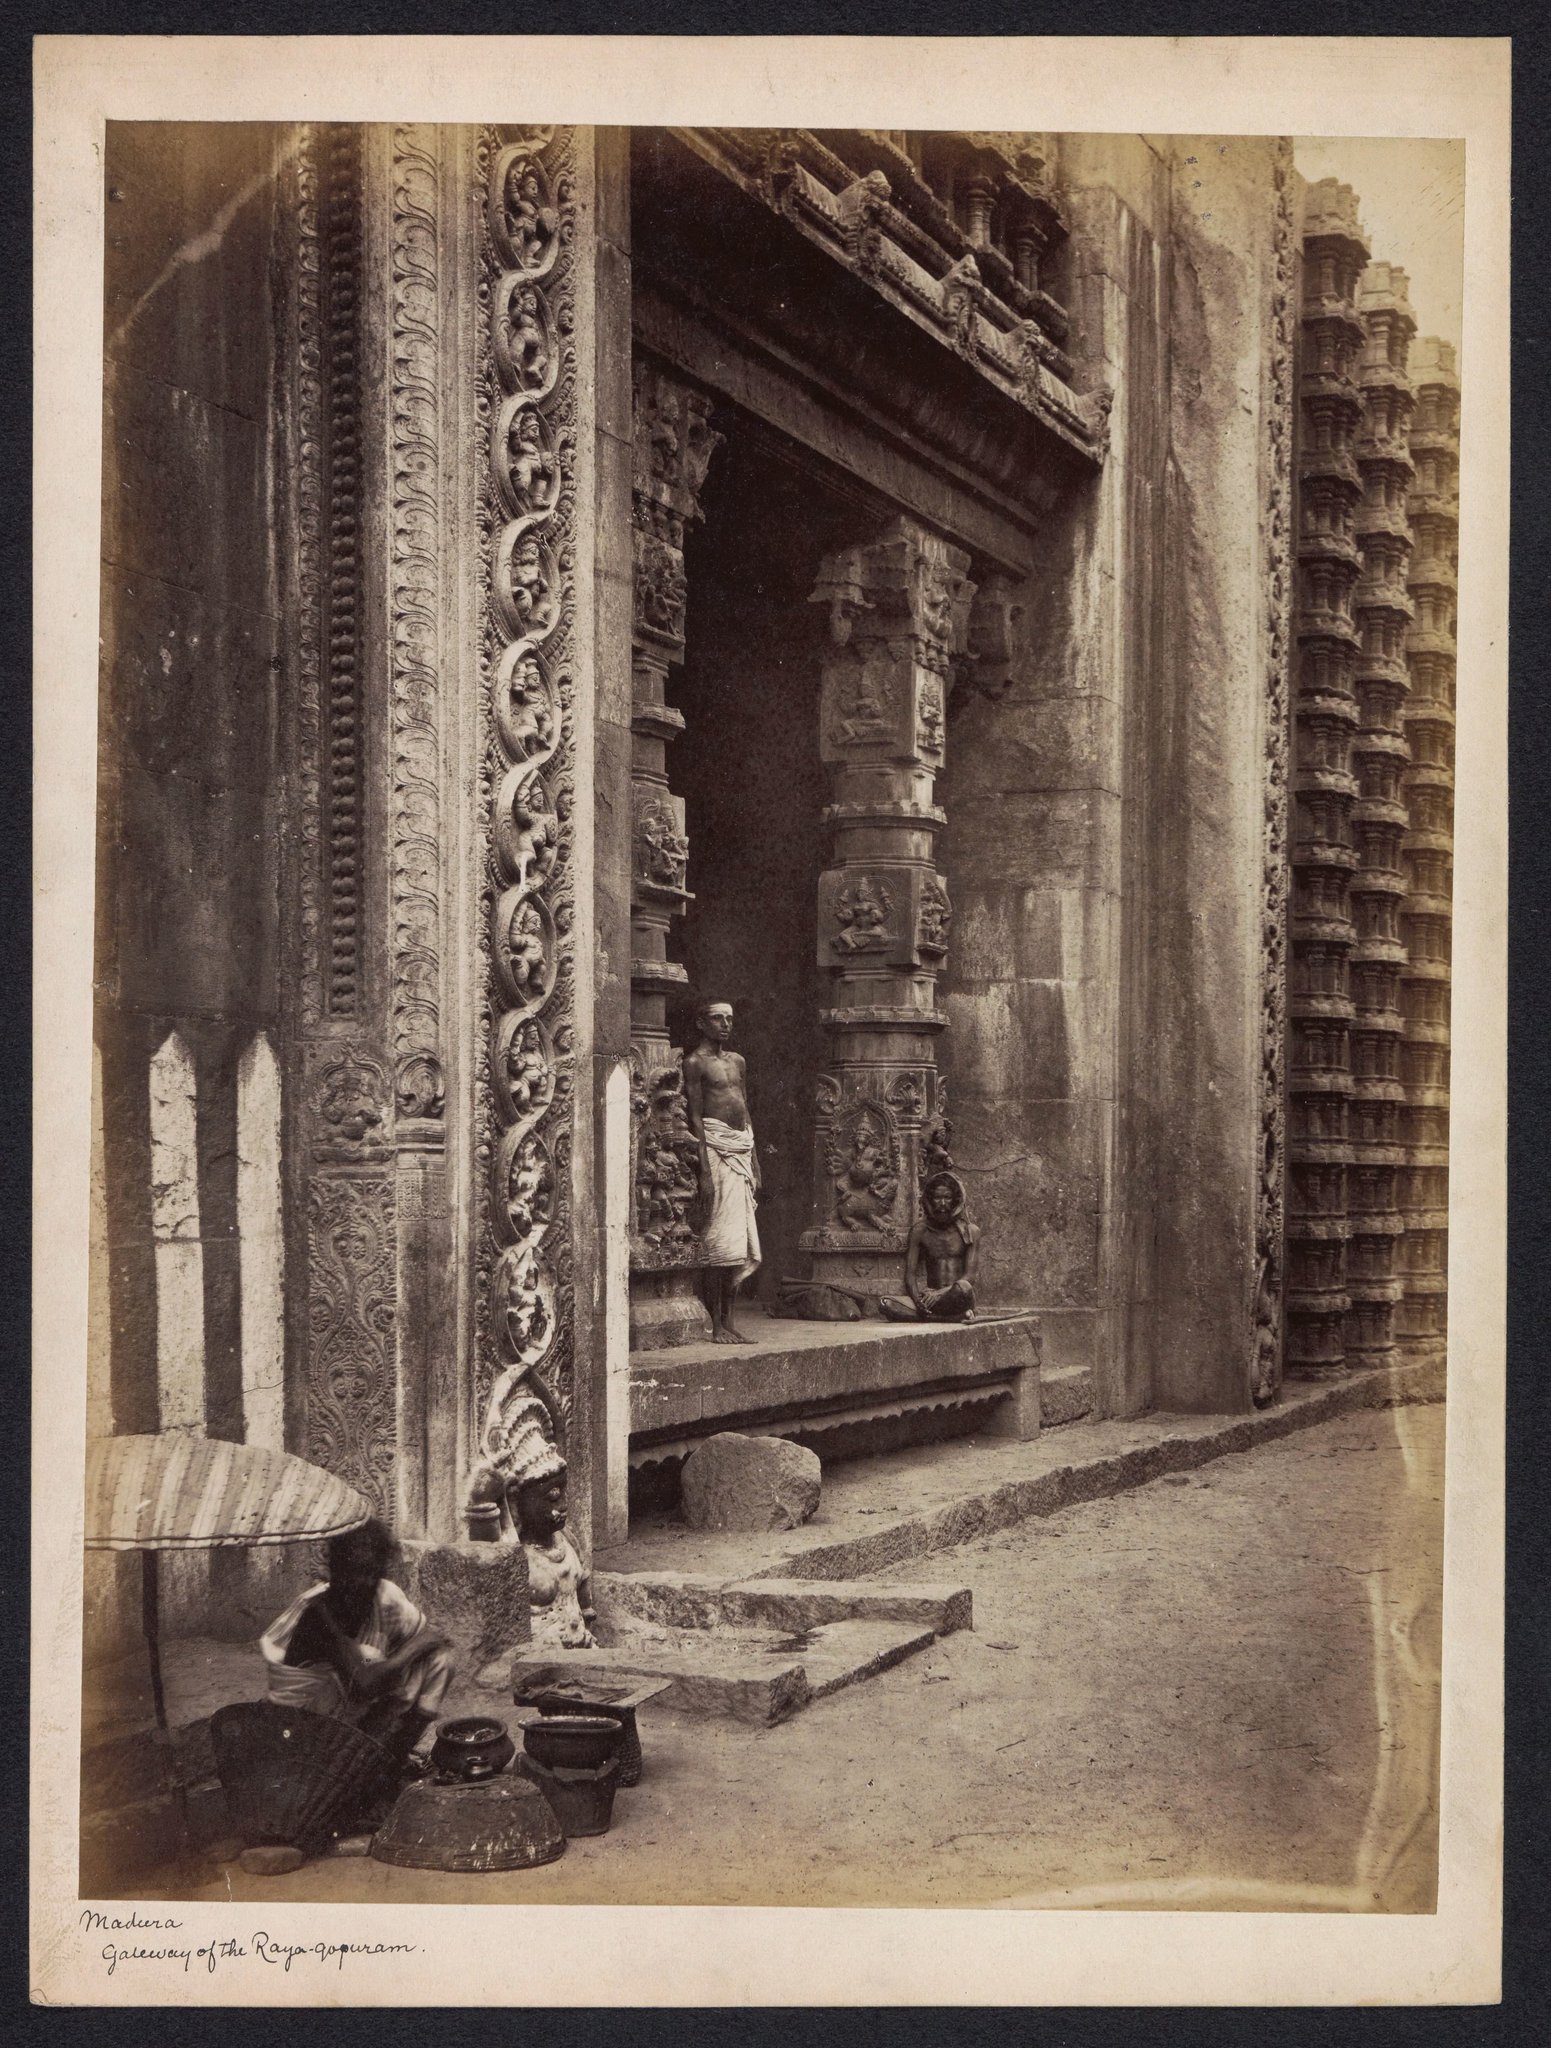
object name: photograph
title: Portret van een onbekende man en vrouw met twee kinderen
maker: Anonymous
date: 1907-1915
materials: photographic support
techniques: gelatin silver print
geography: great britain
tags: parents with their children, façade (of house or building)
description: Man en kind zijn ook gefotografeerd in RP-F-F20512.